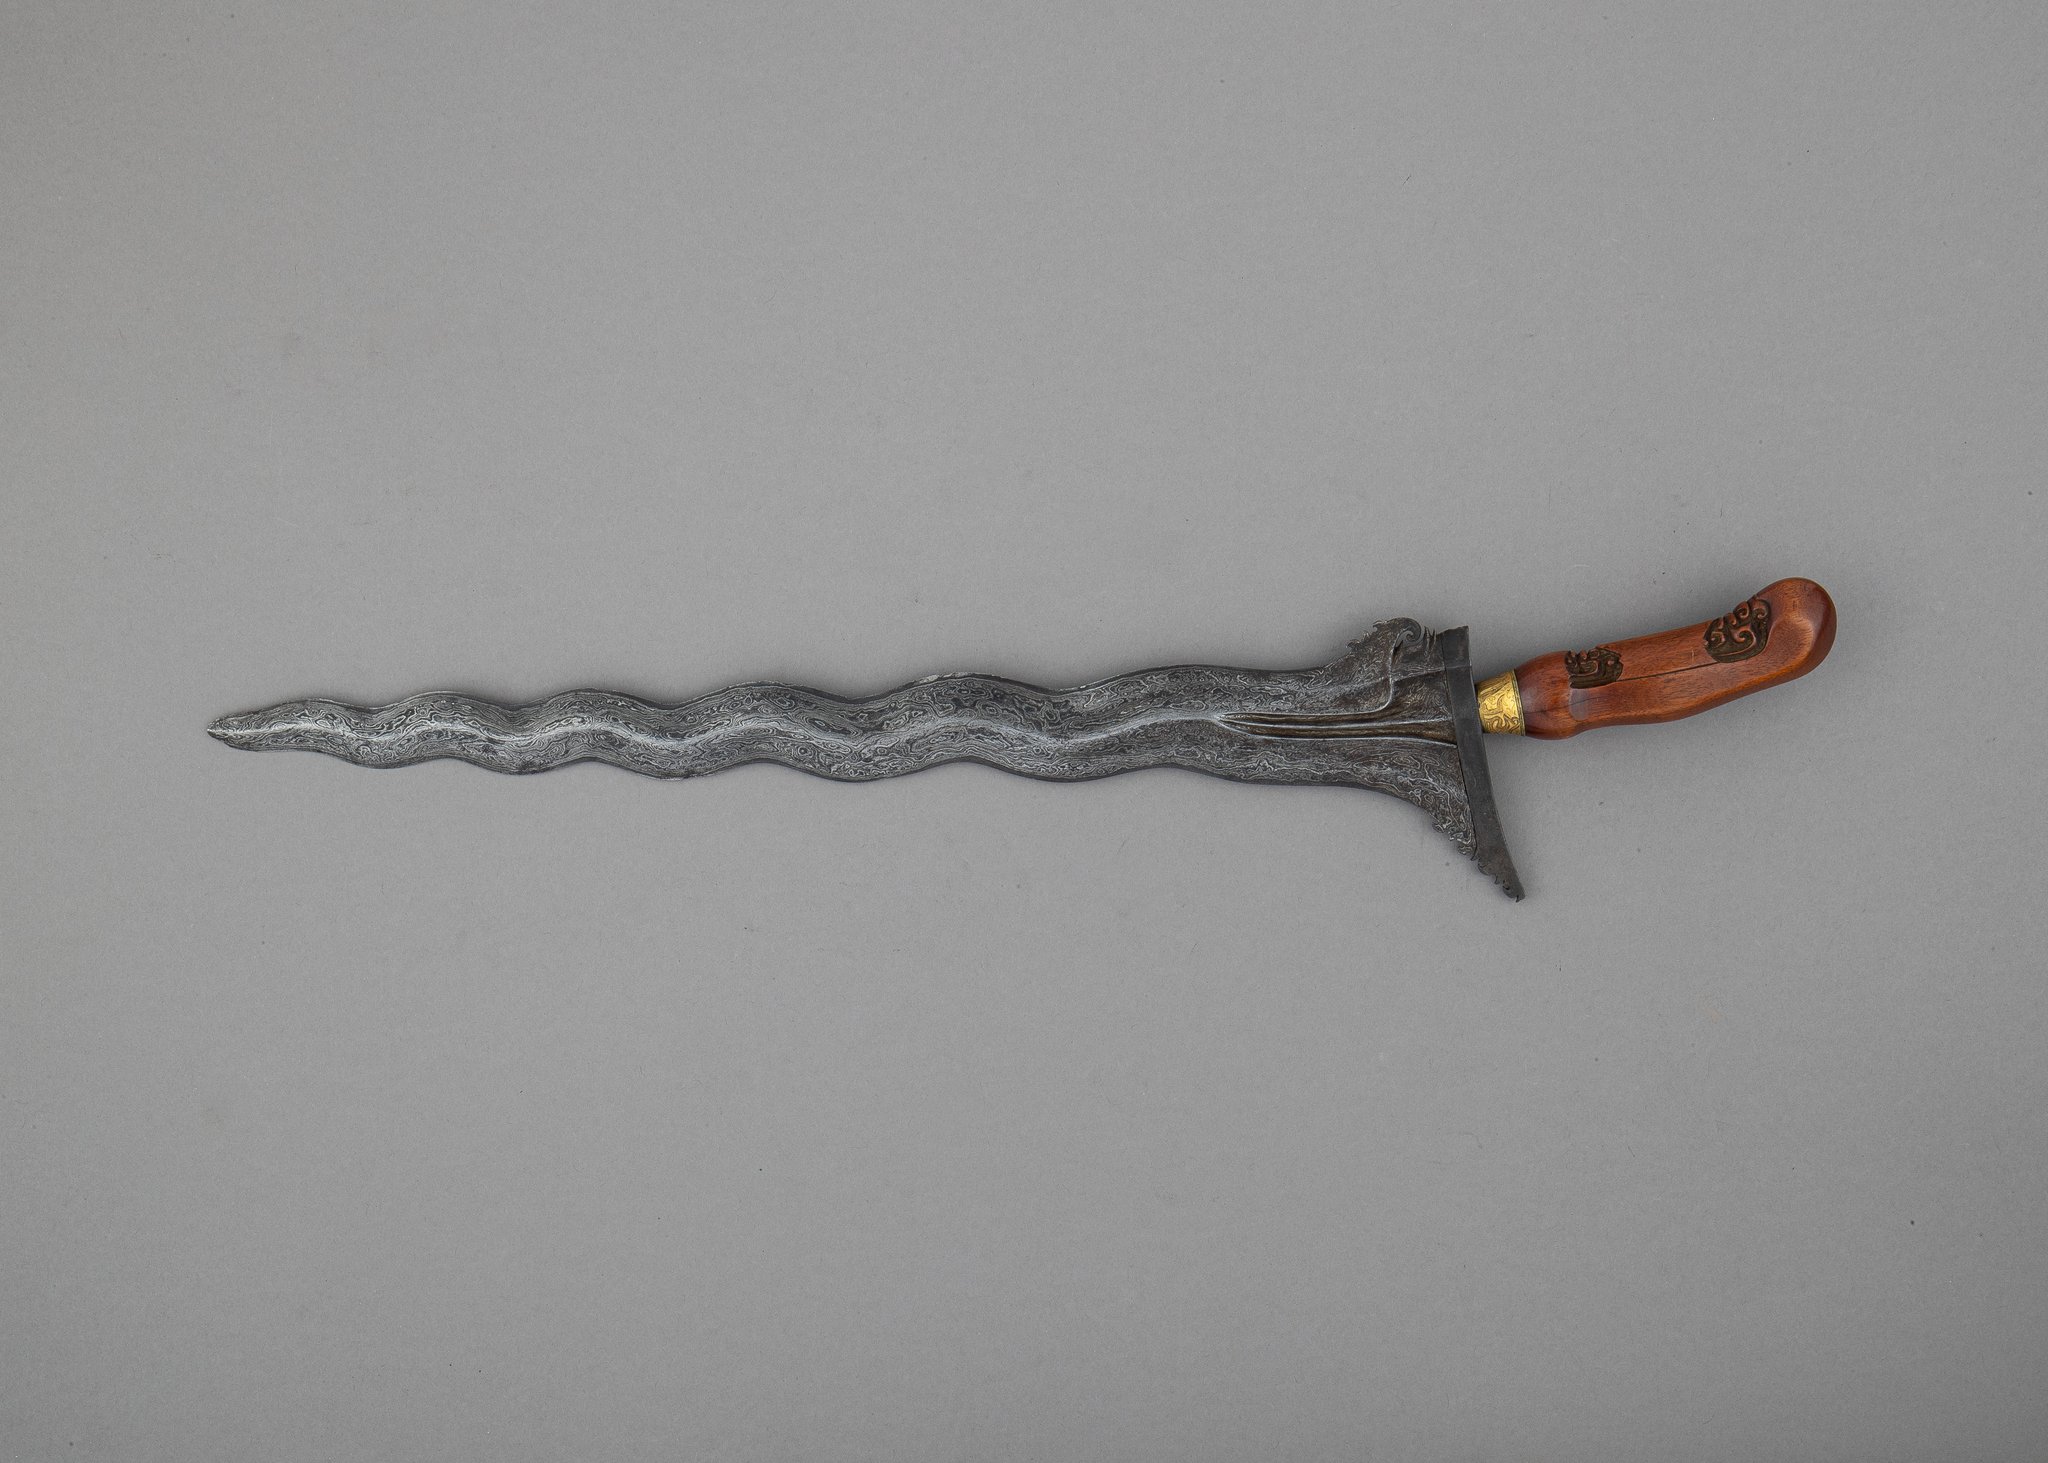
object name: kris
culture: javanese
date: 1501-1900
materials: gold, steel, wood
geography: indonesia